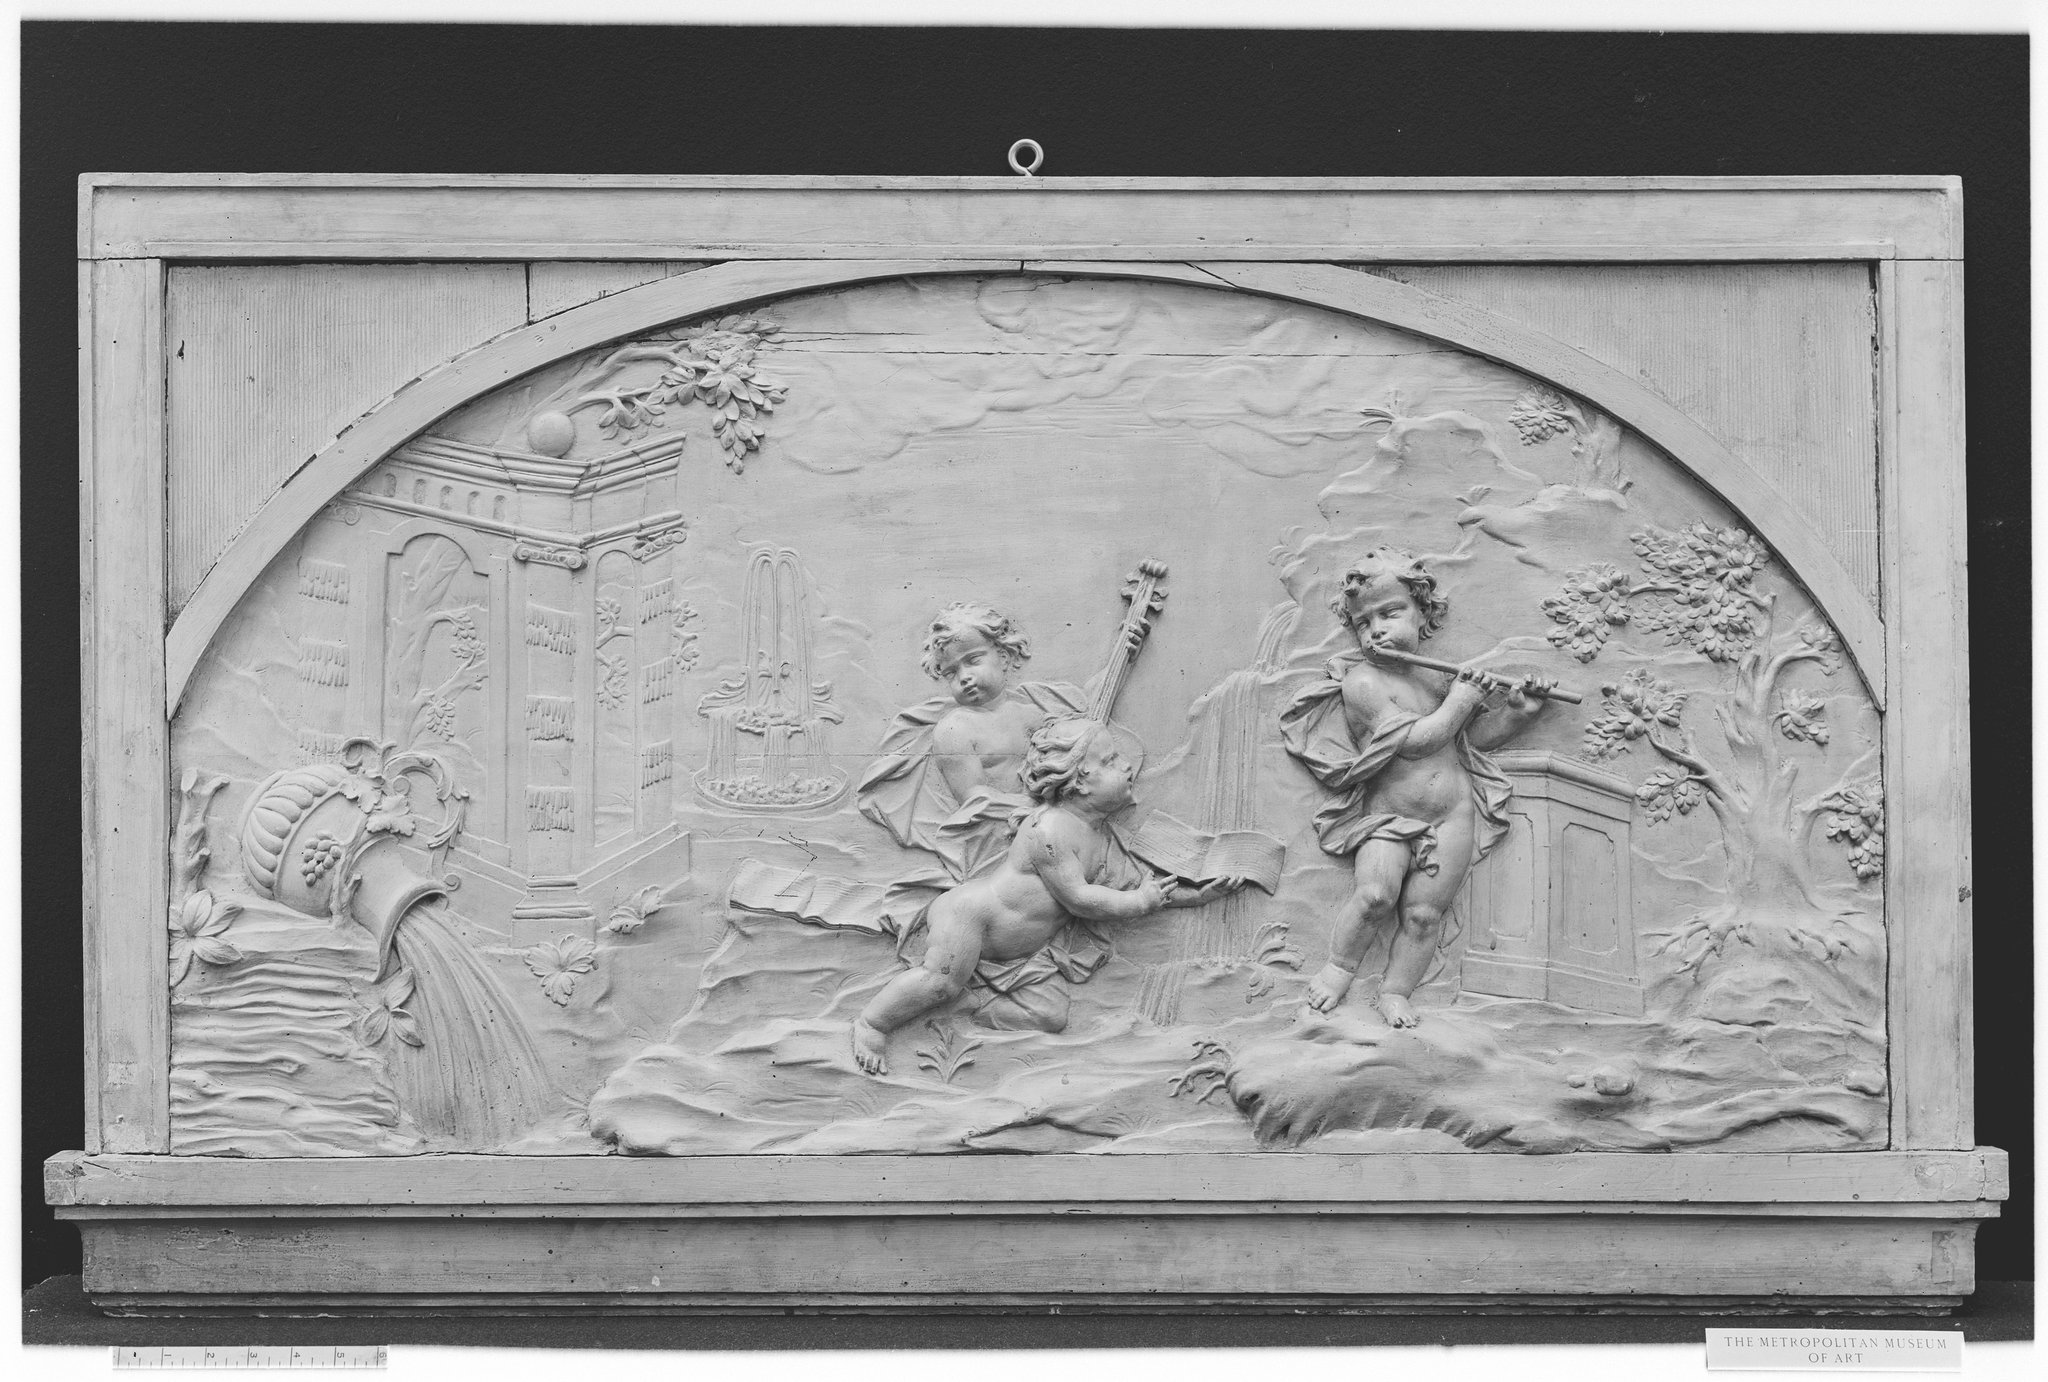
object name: overdoor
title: Overdoor (Dessus de porte)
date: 1701-1800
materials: wood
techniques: carving, painting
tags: musical instruments,infants,flutes